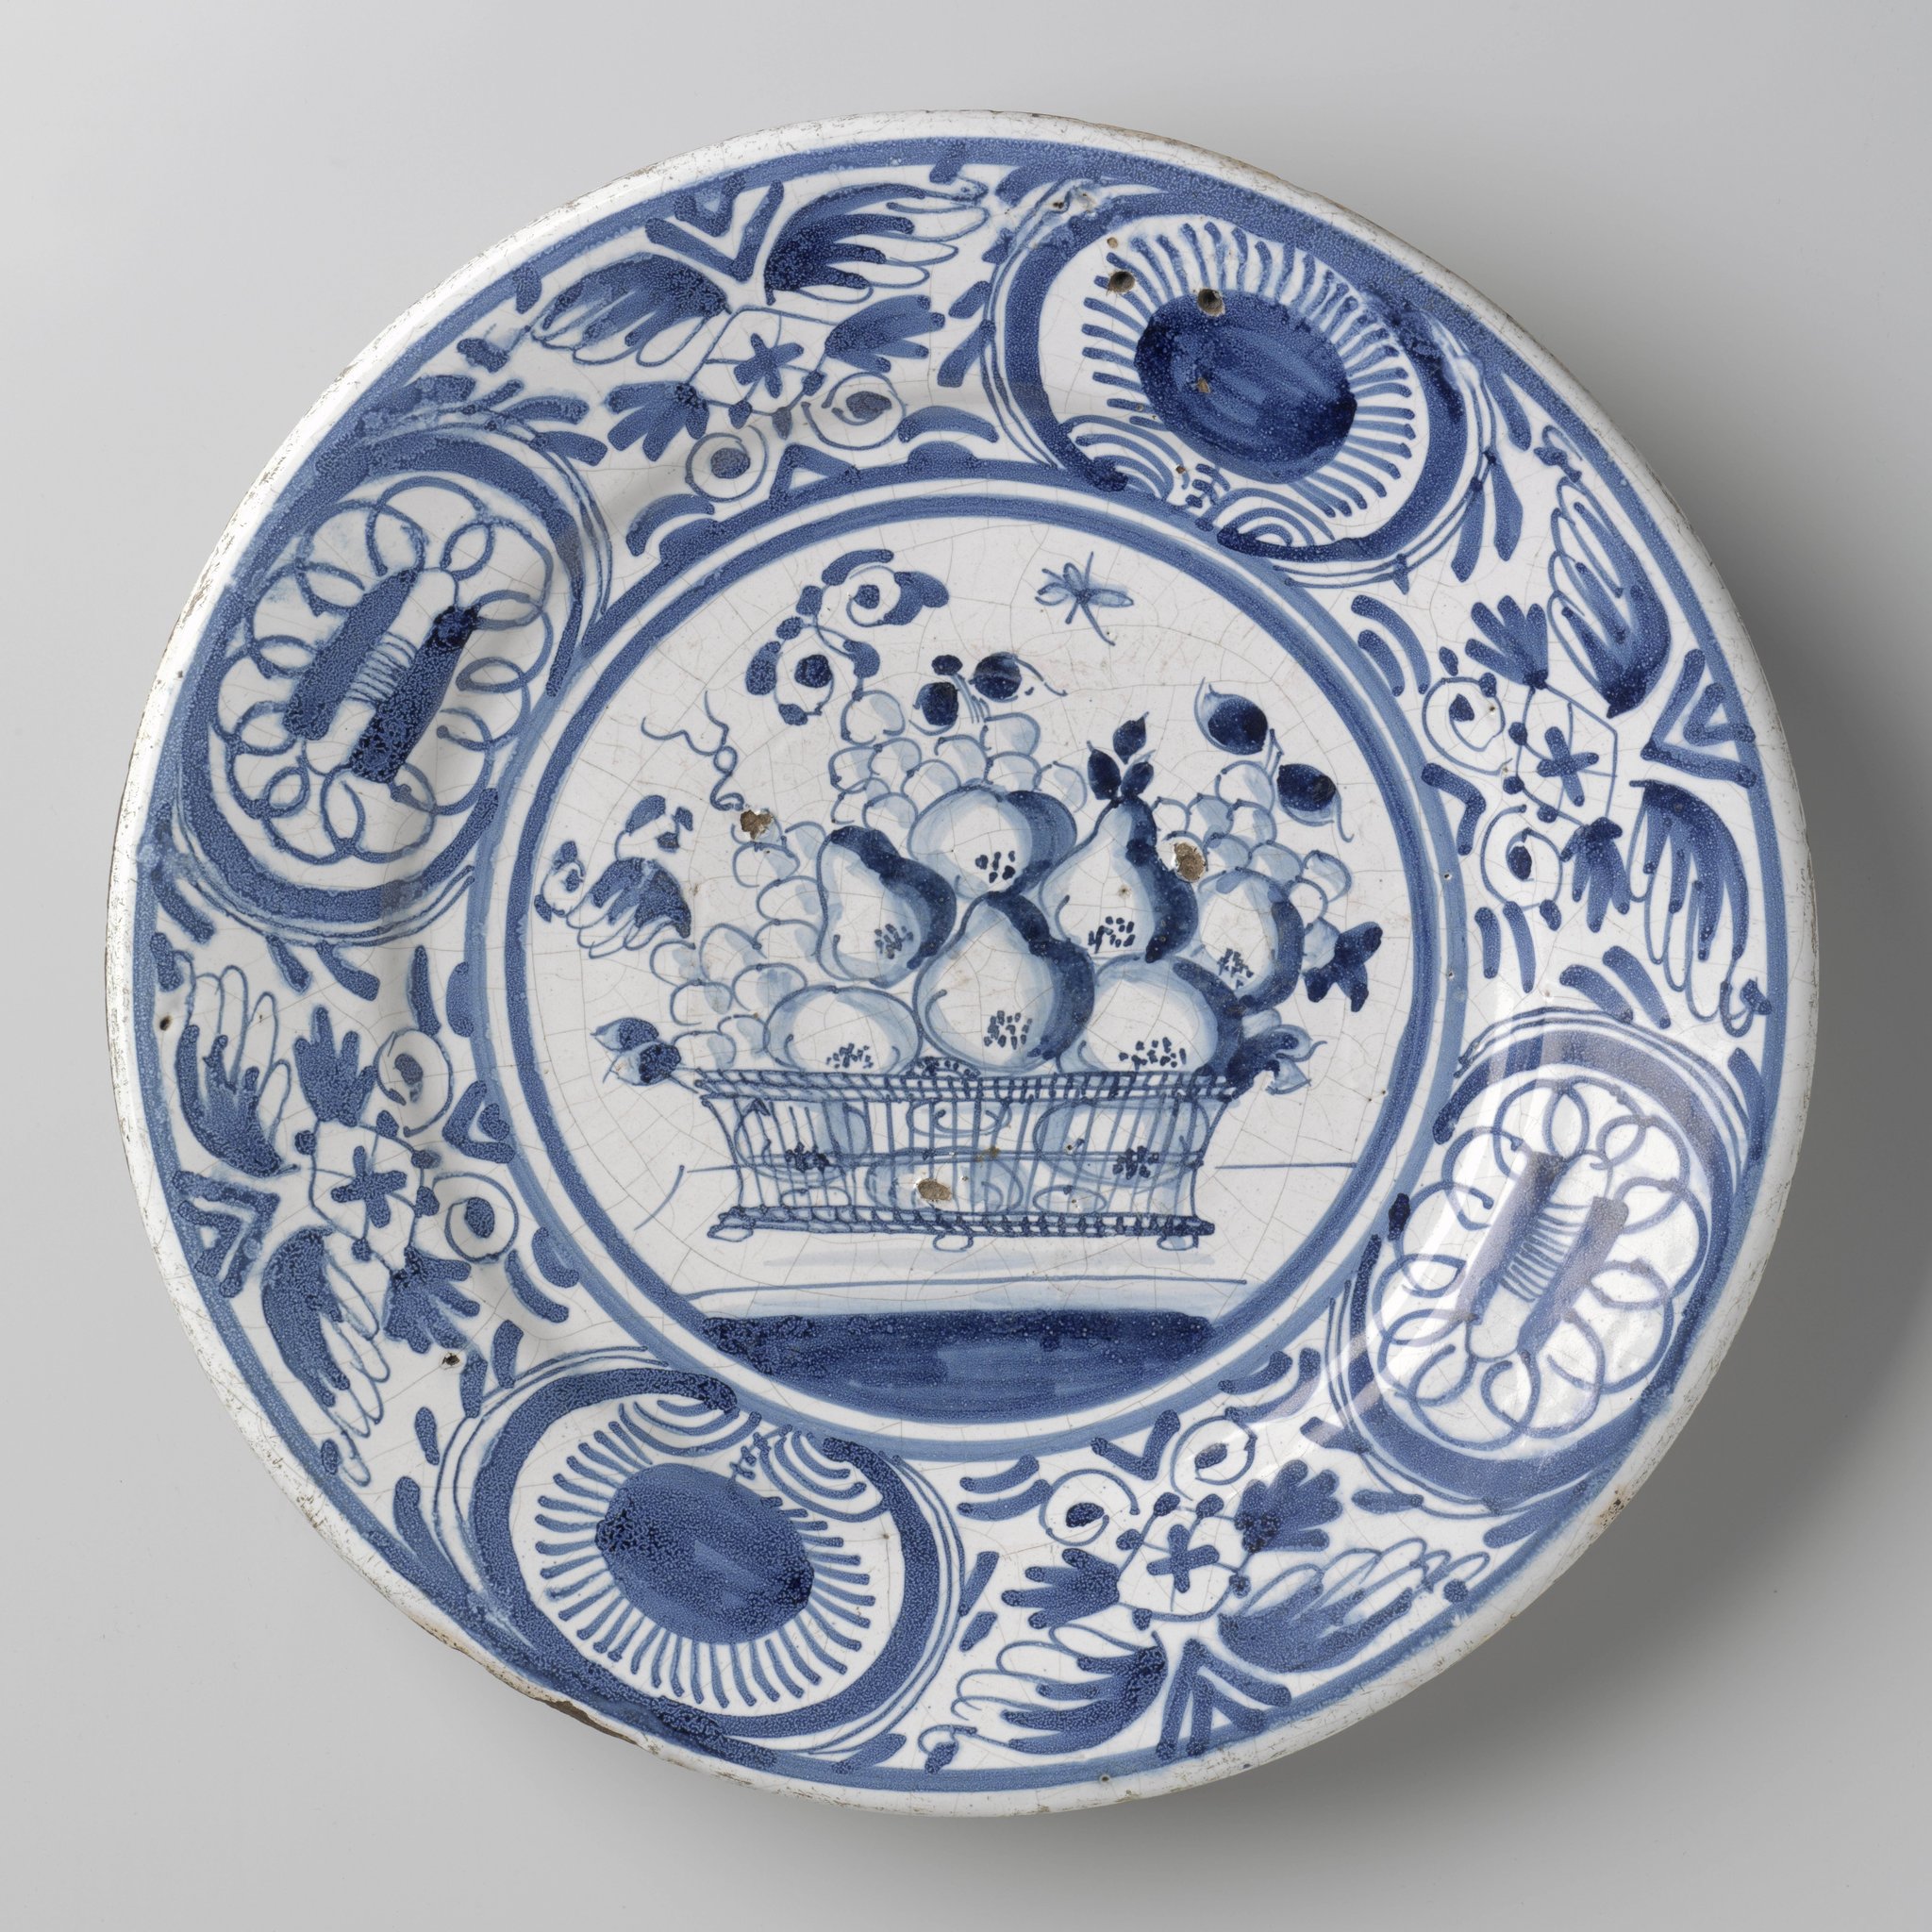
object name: platter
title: Schotel van blauwe majolica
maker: Anonymous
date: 1640-1675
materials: earthenware, glaze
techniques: maiolica, painted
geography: netherlands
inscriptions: : ‘Faience européenne XVIIe/ hors catalogue/ Amsterdam, Rijksmuseum’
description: Dish. C. 1640 - 1675. Gift from the heirs of A. Isaac, 1955.